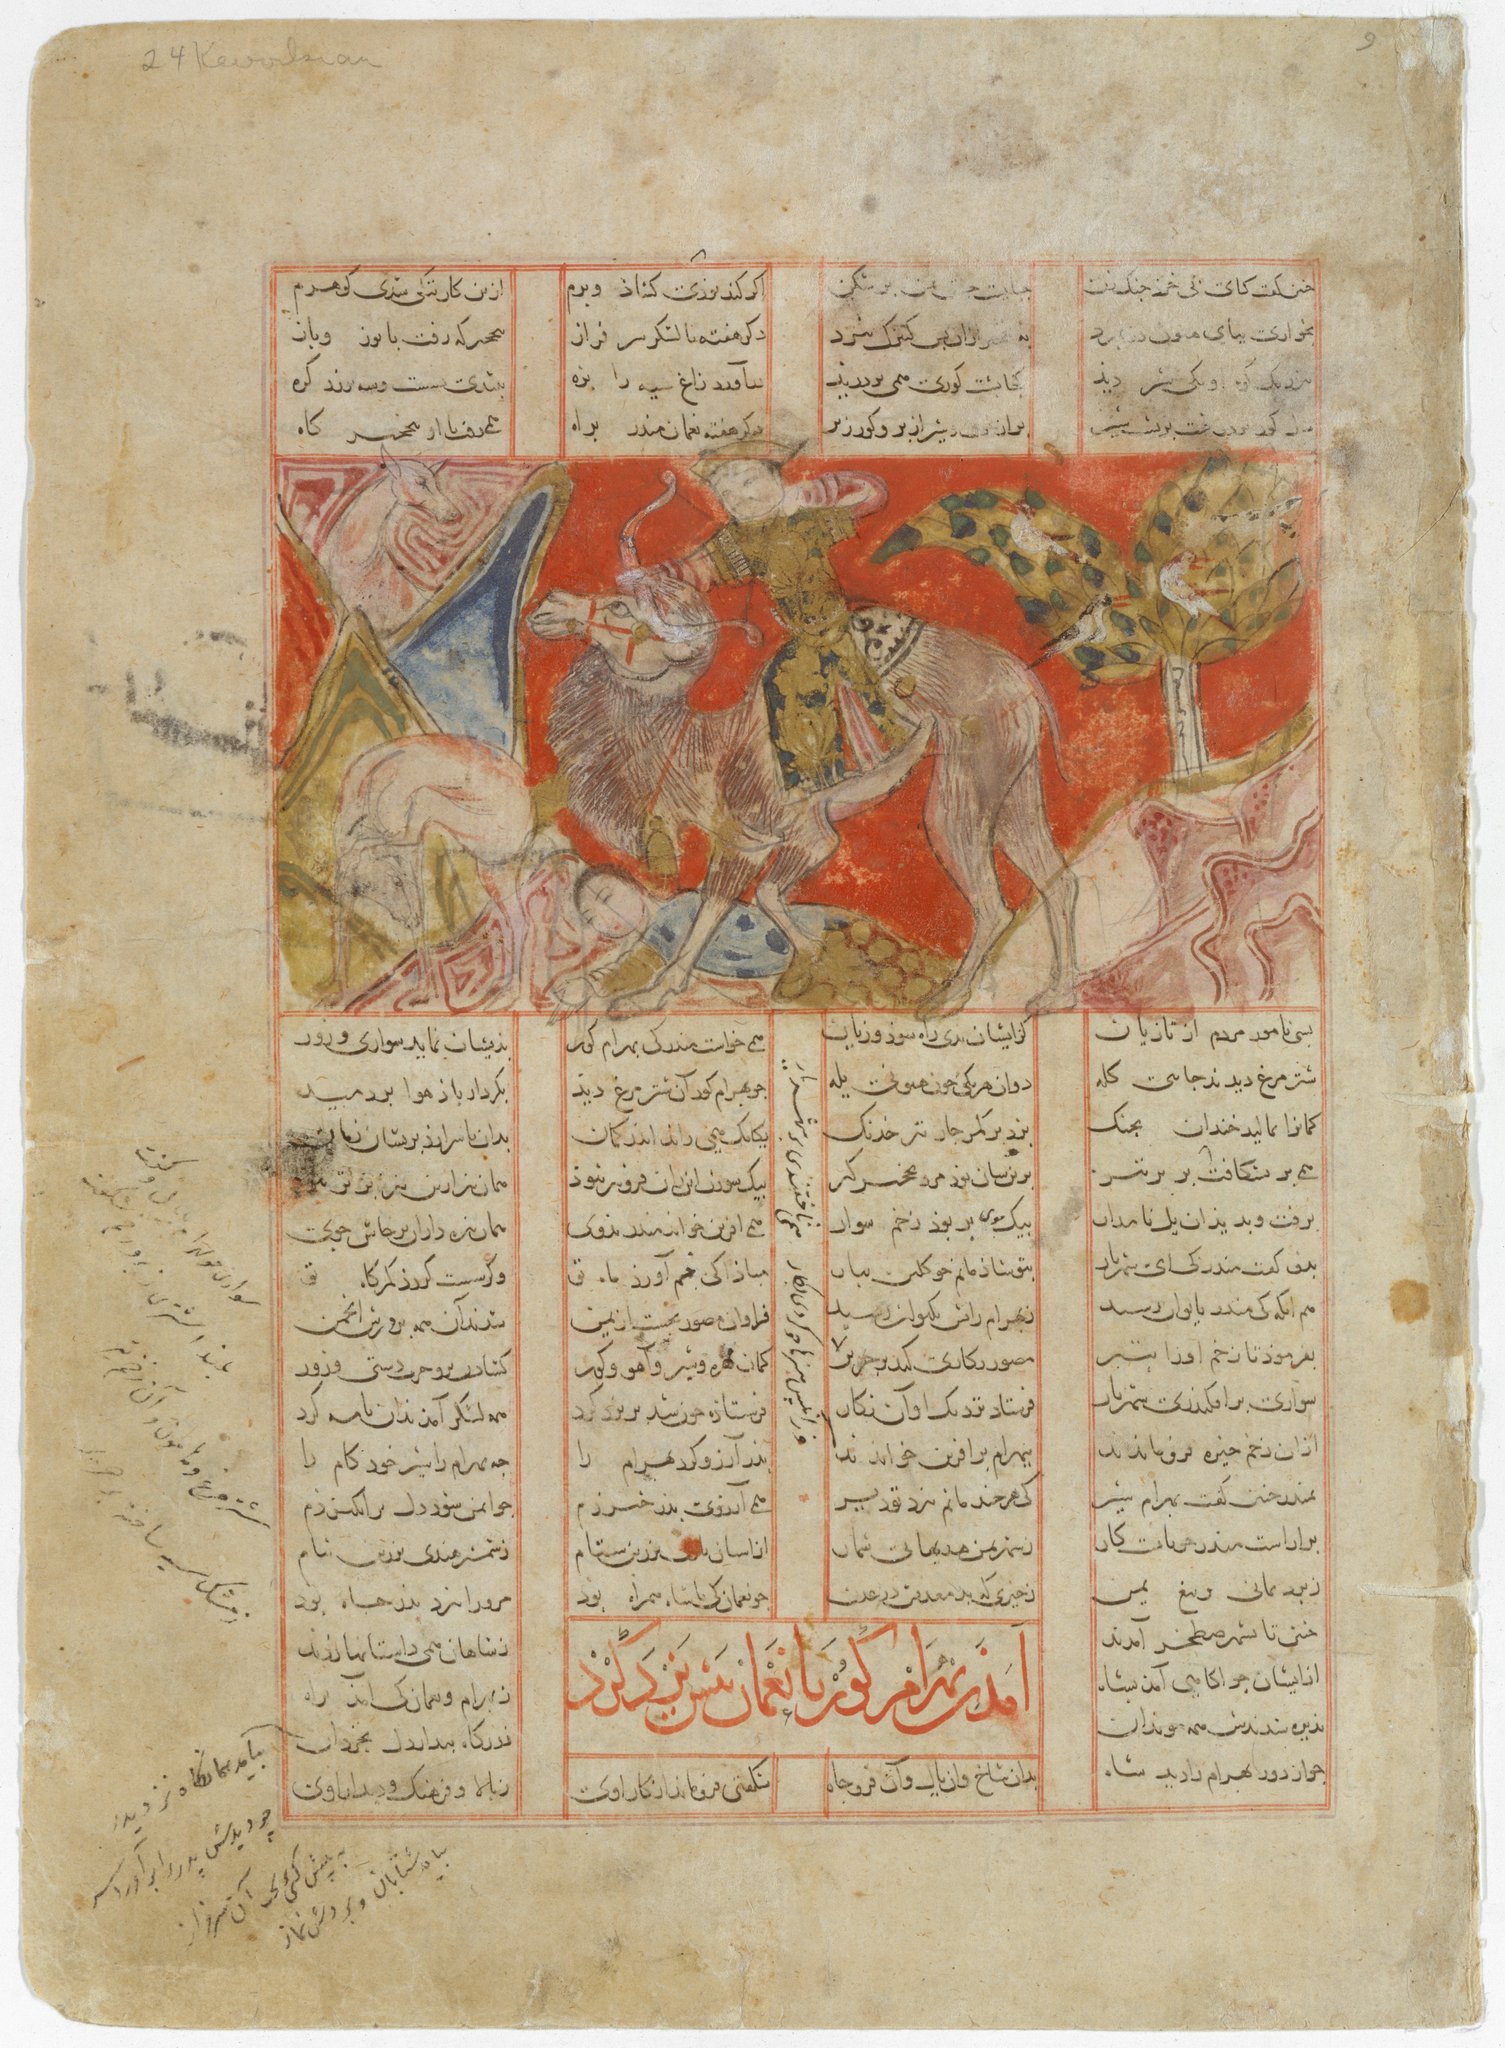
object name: folio from an illustrated manuscript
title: "Bahram Gur Hunting with Azada", Folio from a Shahnama (Book of Kings)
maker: abu'l qasim firdausi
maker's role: author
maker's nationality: iranian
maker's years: 935-1020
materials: gold, ink, paper, watercolor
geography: iran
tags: men,hunting,camels